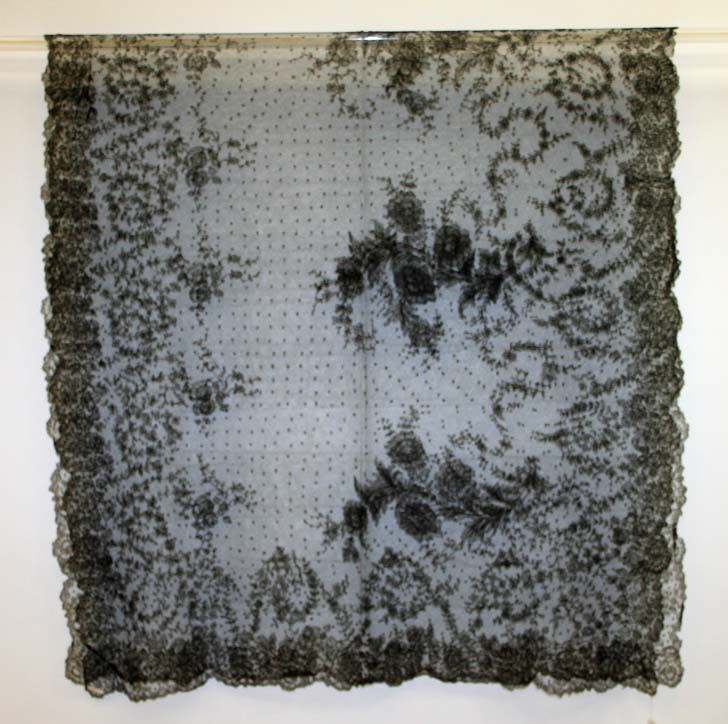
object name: scarf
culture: french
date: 1867-1900